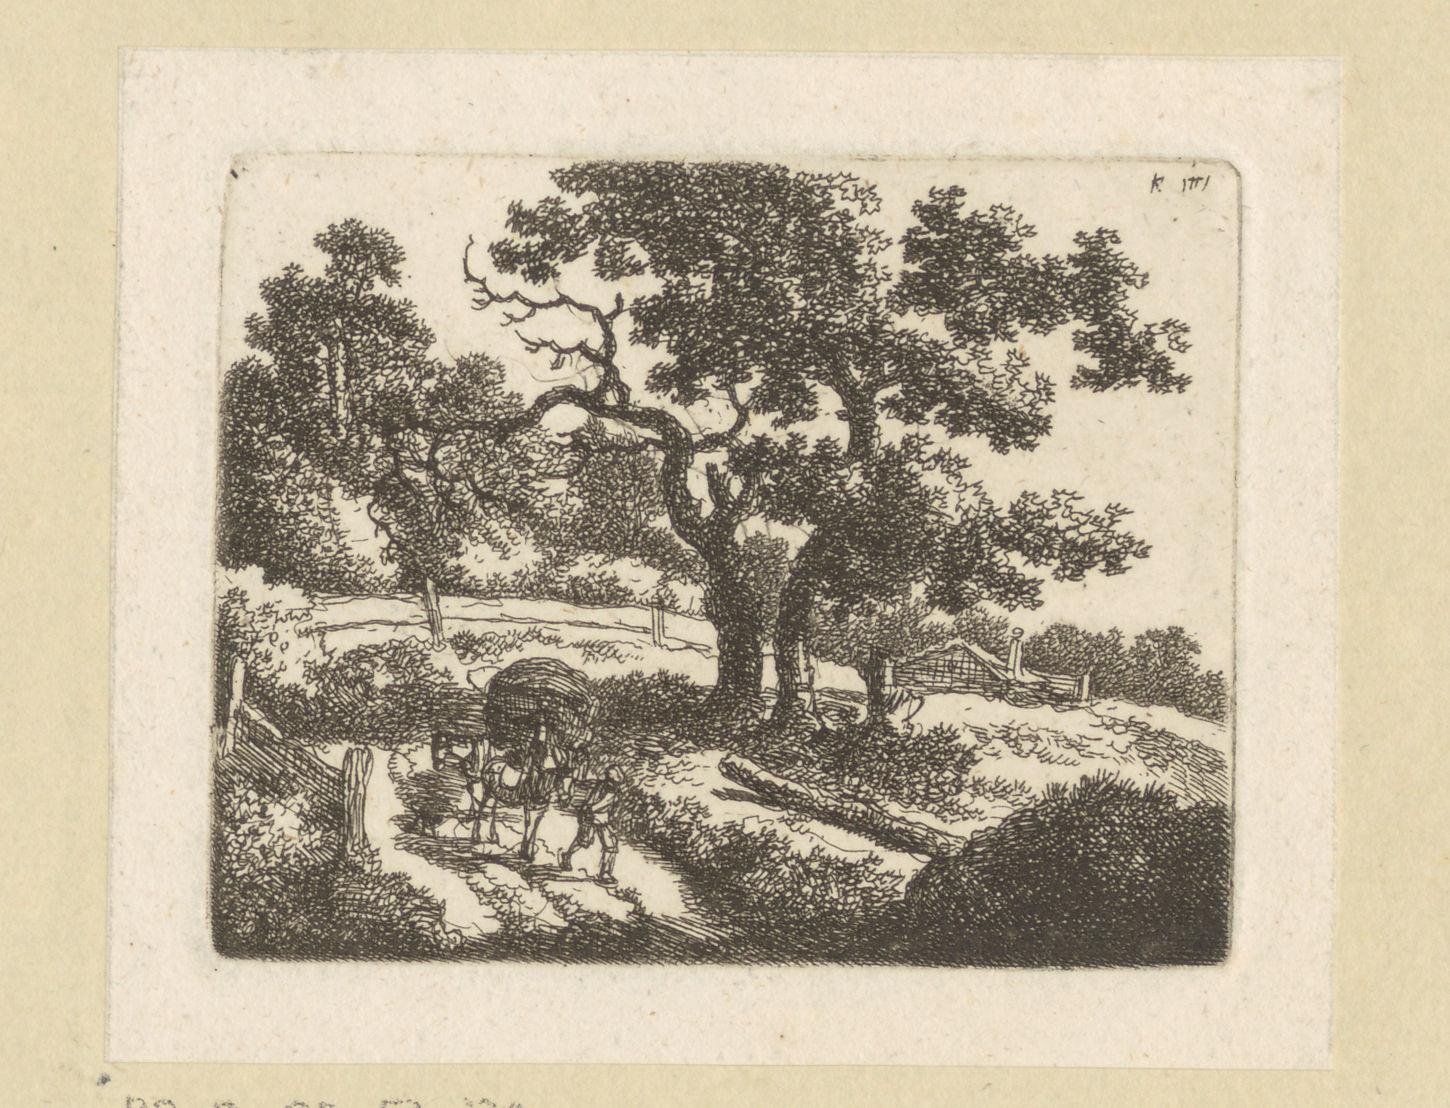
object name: print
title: Landschap met een boer en een beladen kar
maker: johann christian klengel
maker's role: print maker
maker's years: 1751-1824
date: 1771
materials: paper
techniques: etching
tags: forest path or lane, (farm) wagon, freight wagon, cart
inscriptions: collector's mark: Lugt 240